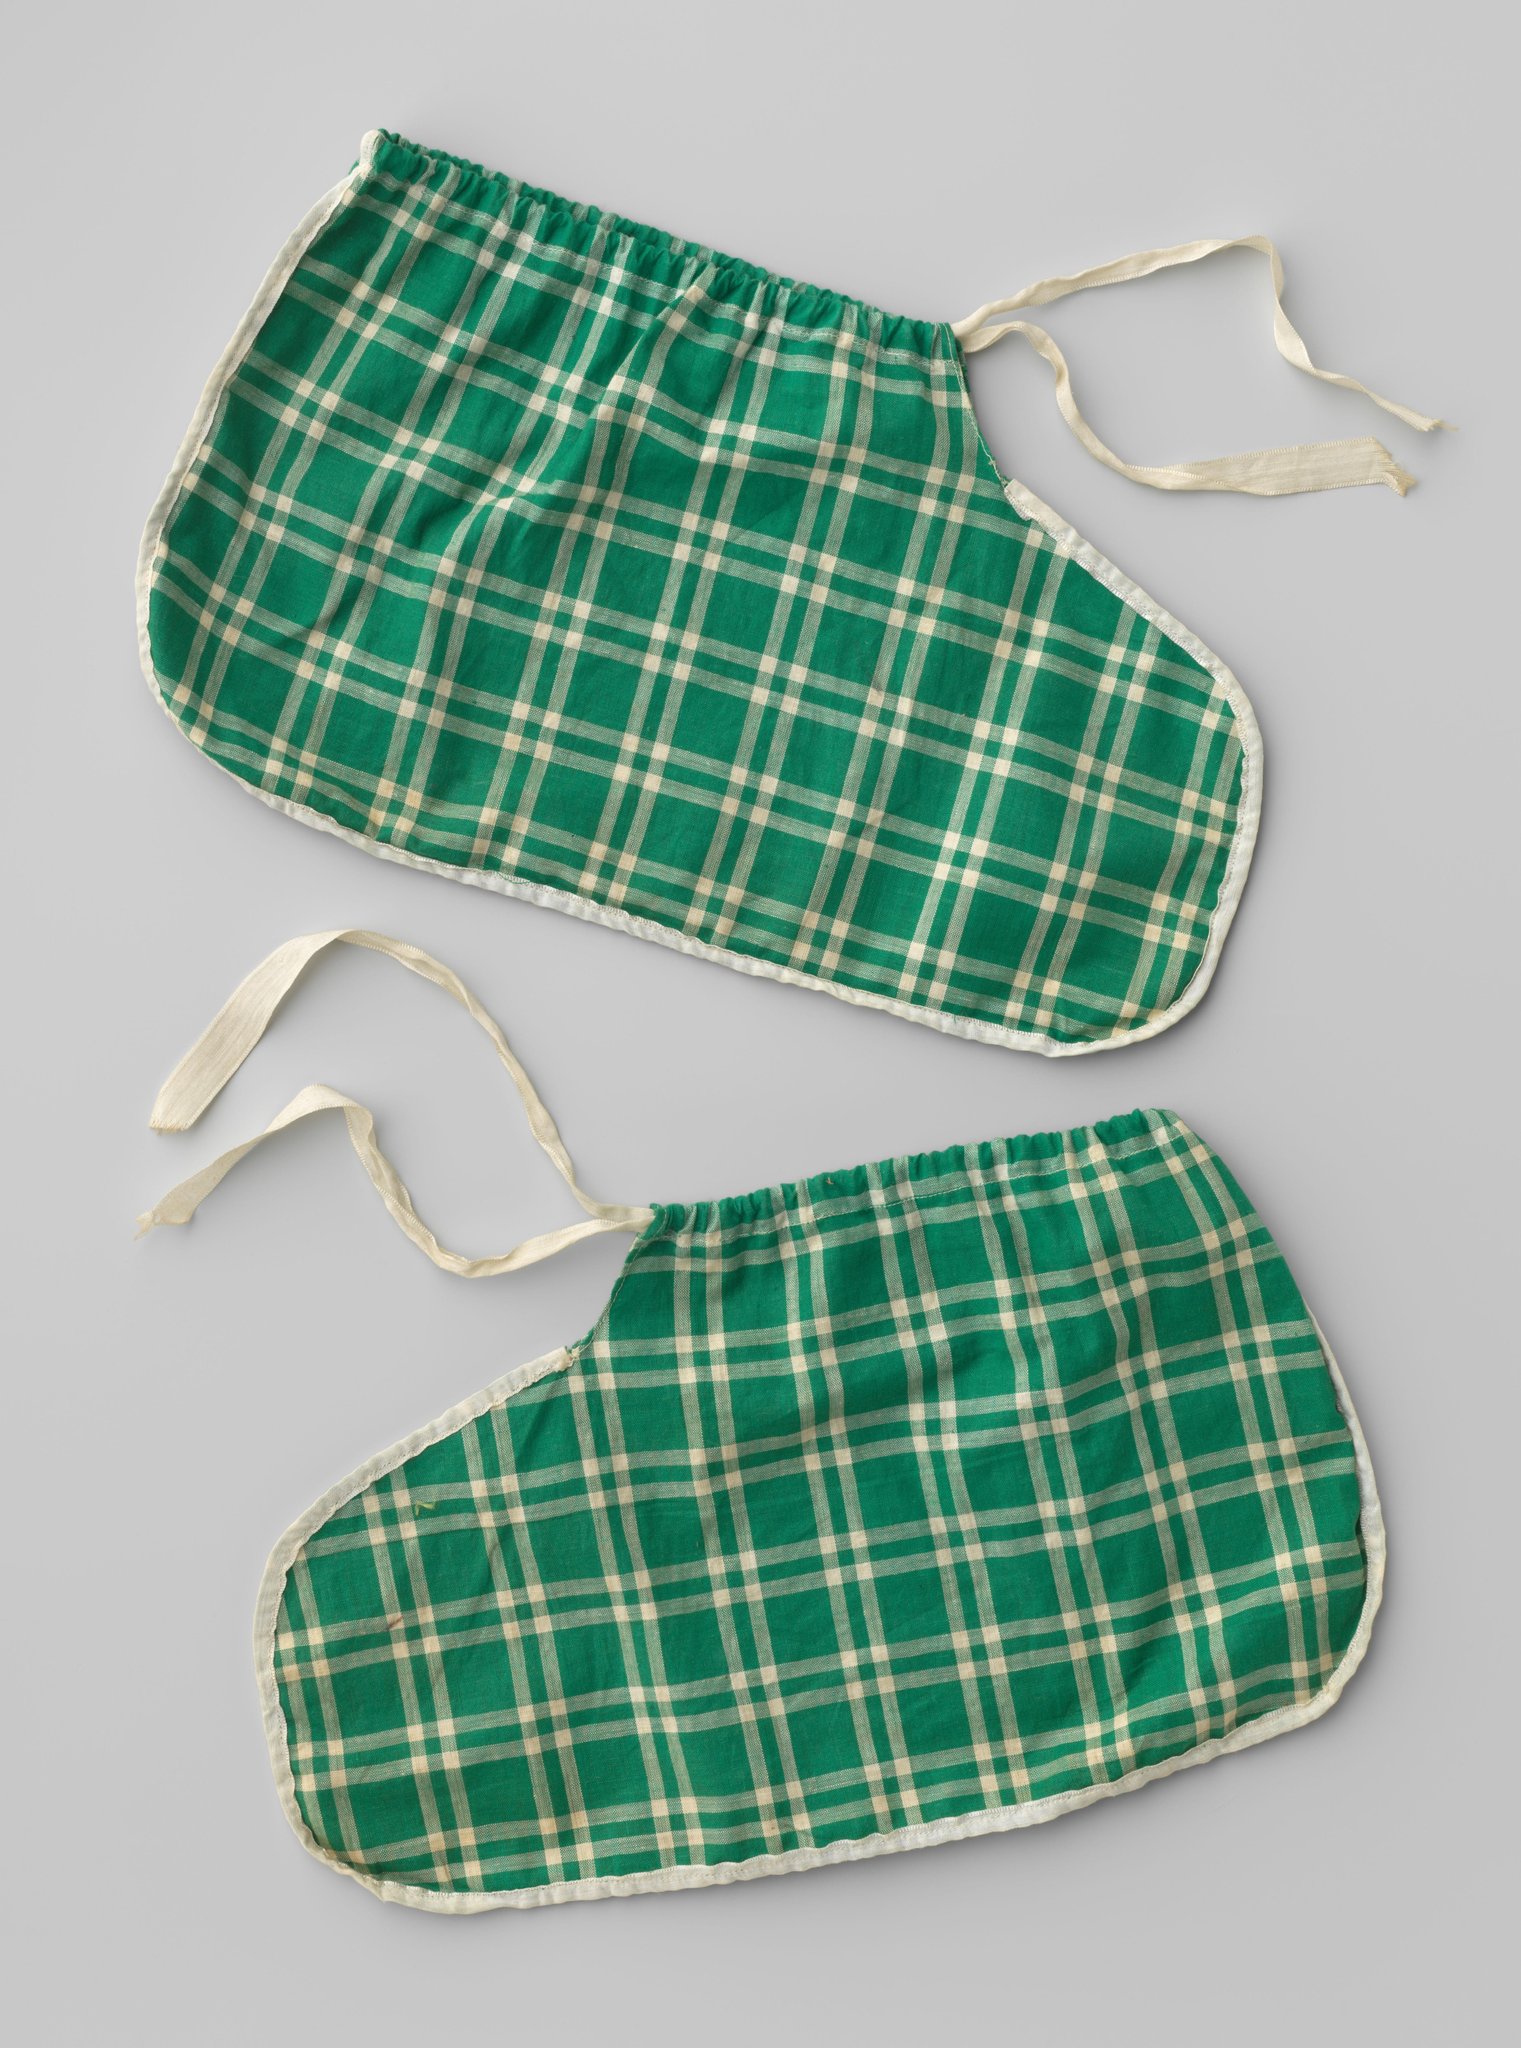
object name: verpakking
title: Schoenenzak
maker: Anonymous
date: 1930-1940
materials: cotton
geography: western europe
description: Schoenenzak van groen/wit geruite katoen afgezet met groen satijnband. Sluiting door middel van een koordje in tunnel. Behorend bij pump van wit wasleer versierd met marineblauw kalfs(?)leer.